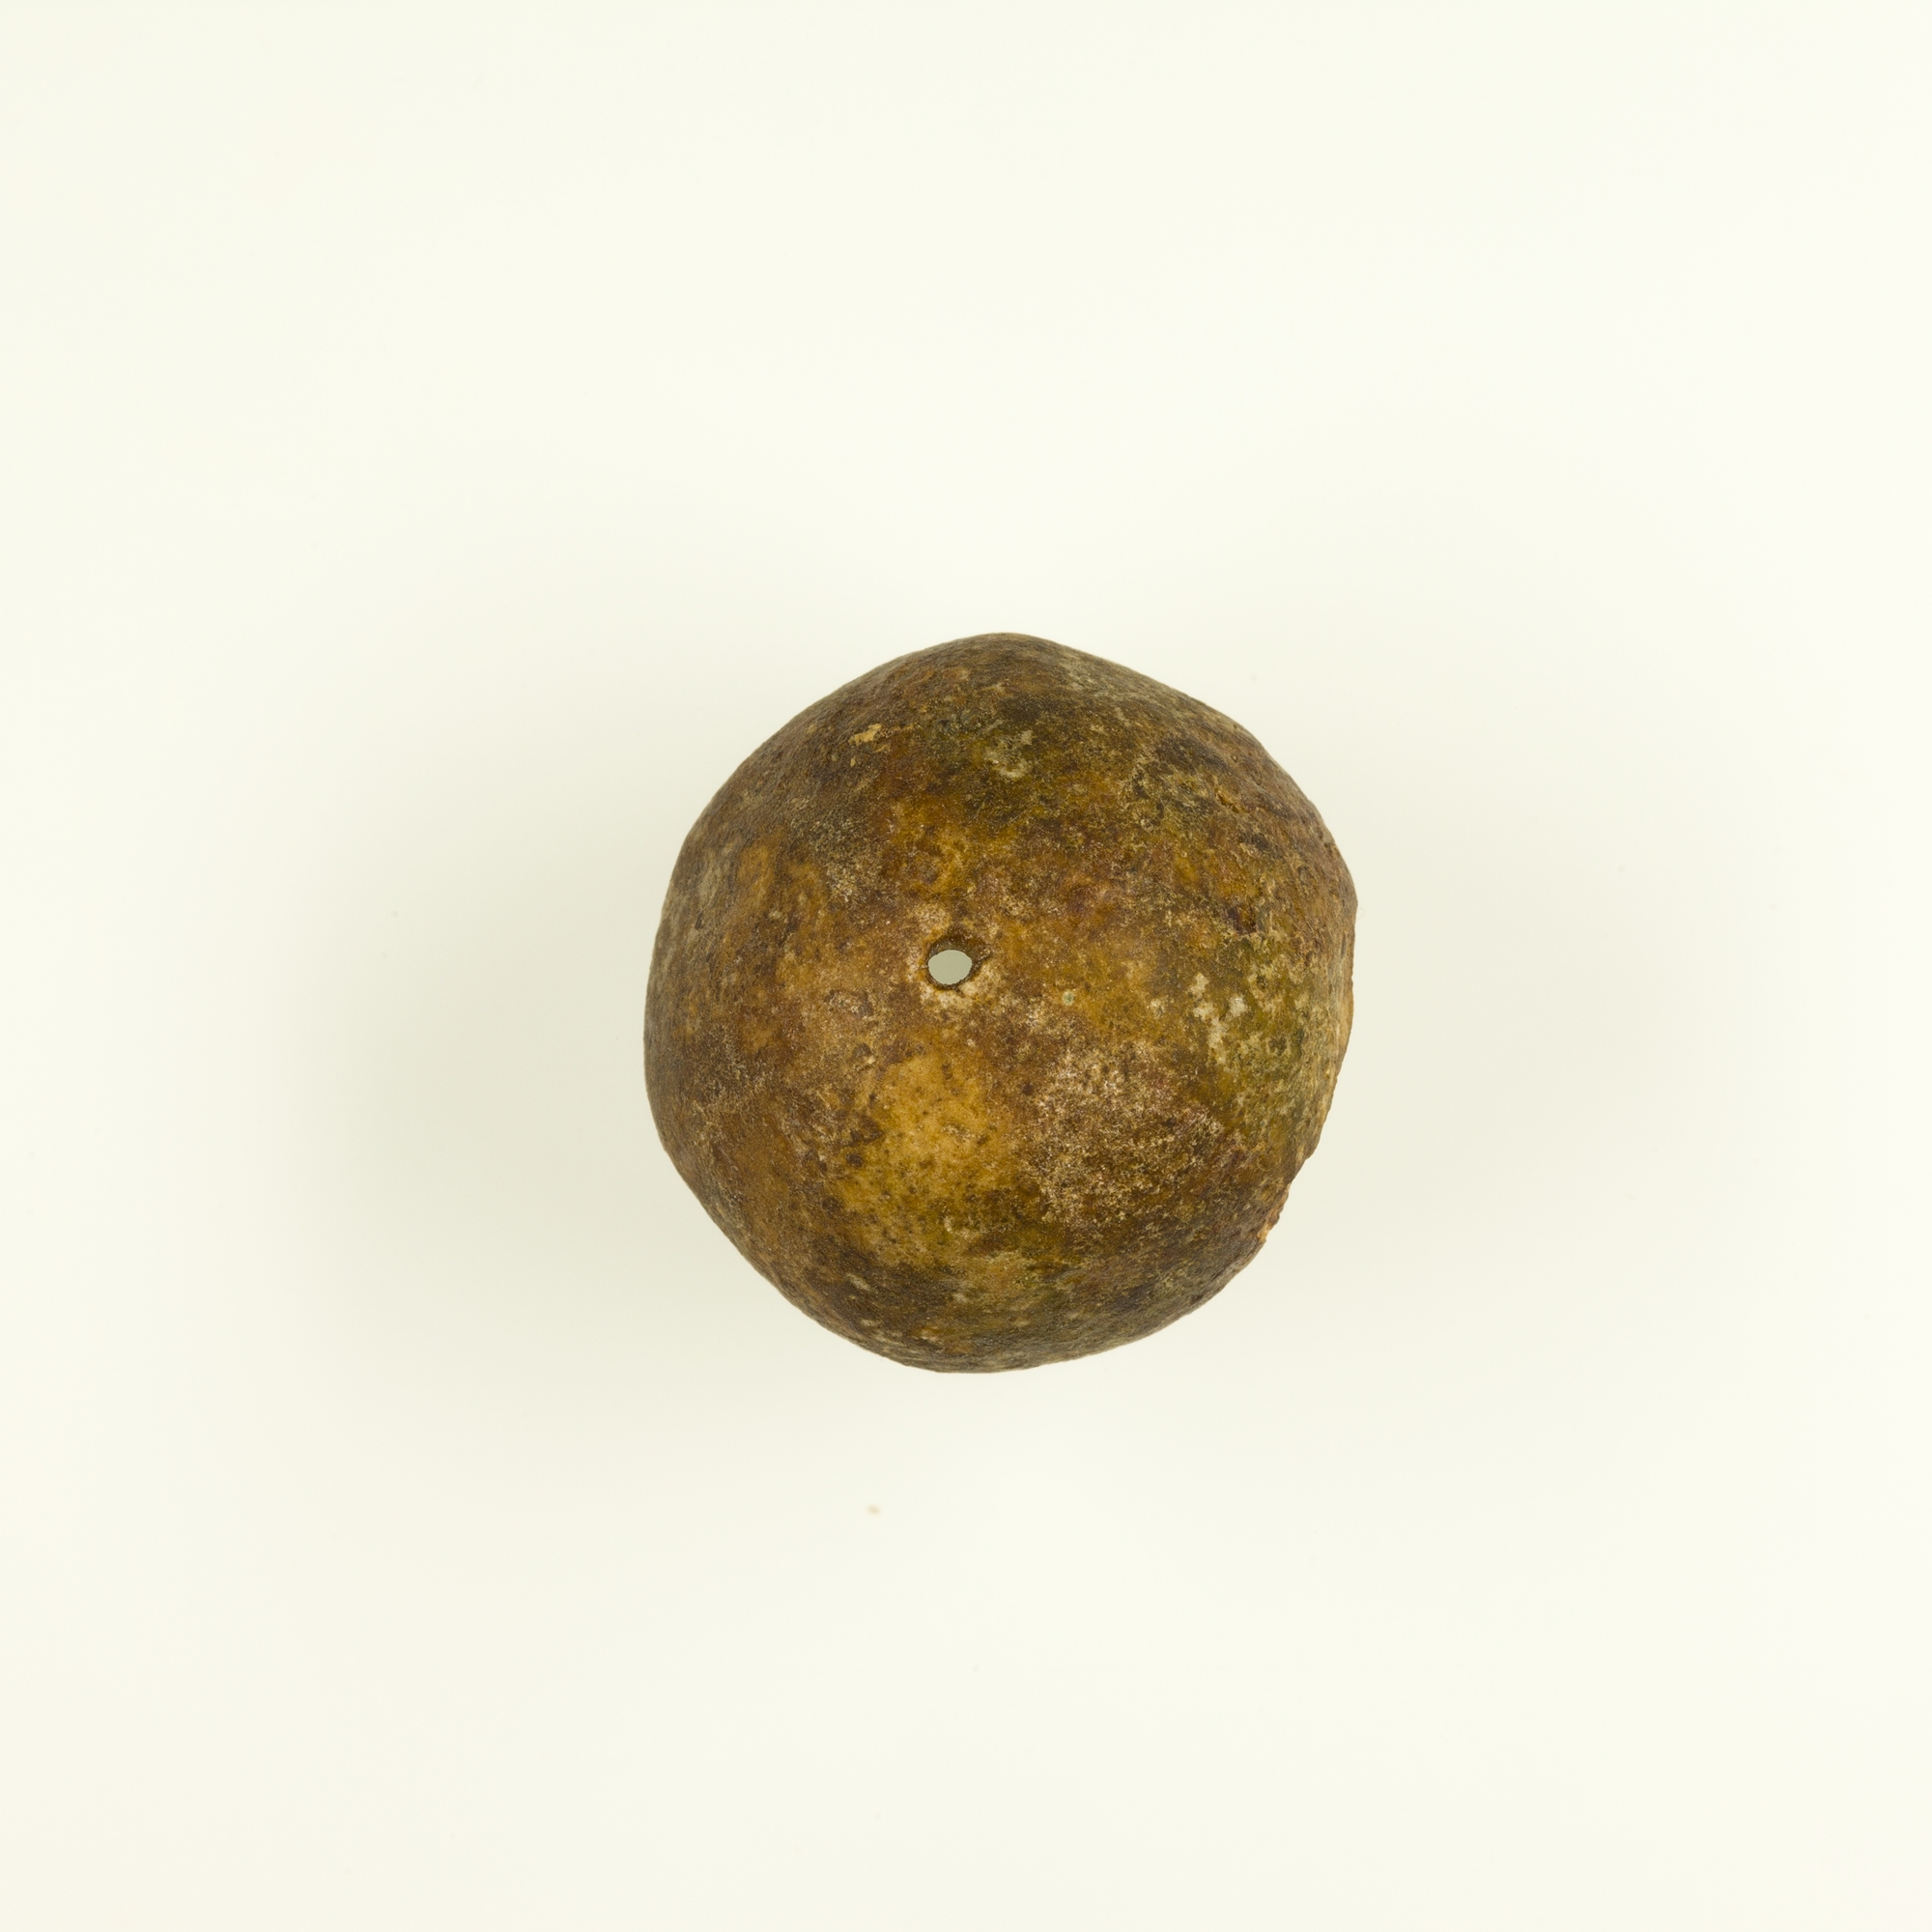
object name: bead, ball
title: Ball bead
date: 1635-1458 BCE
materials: faience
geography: egypt